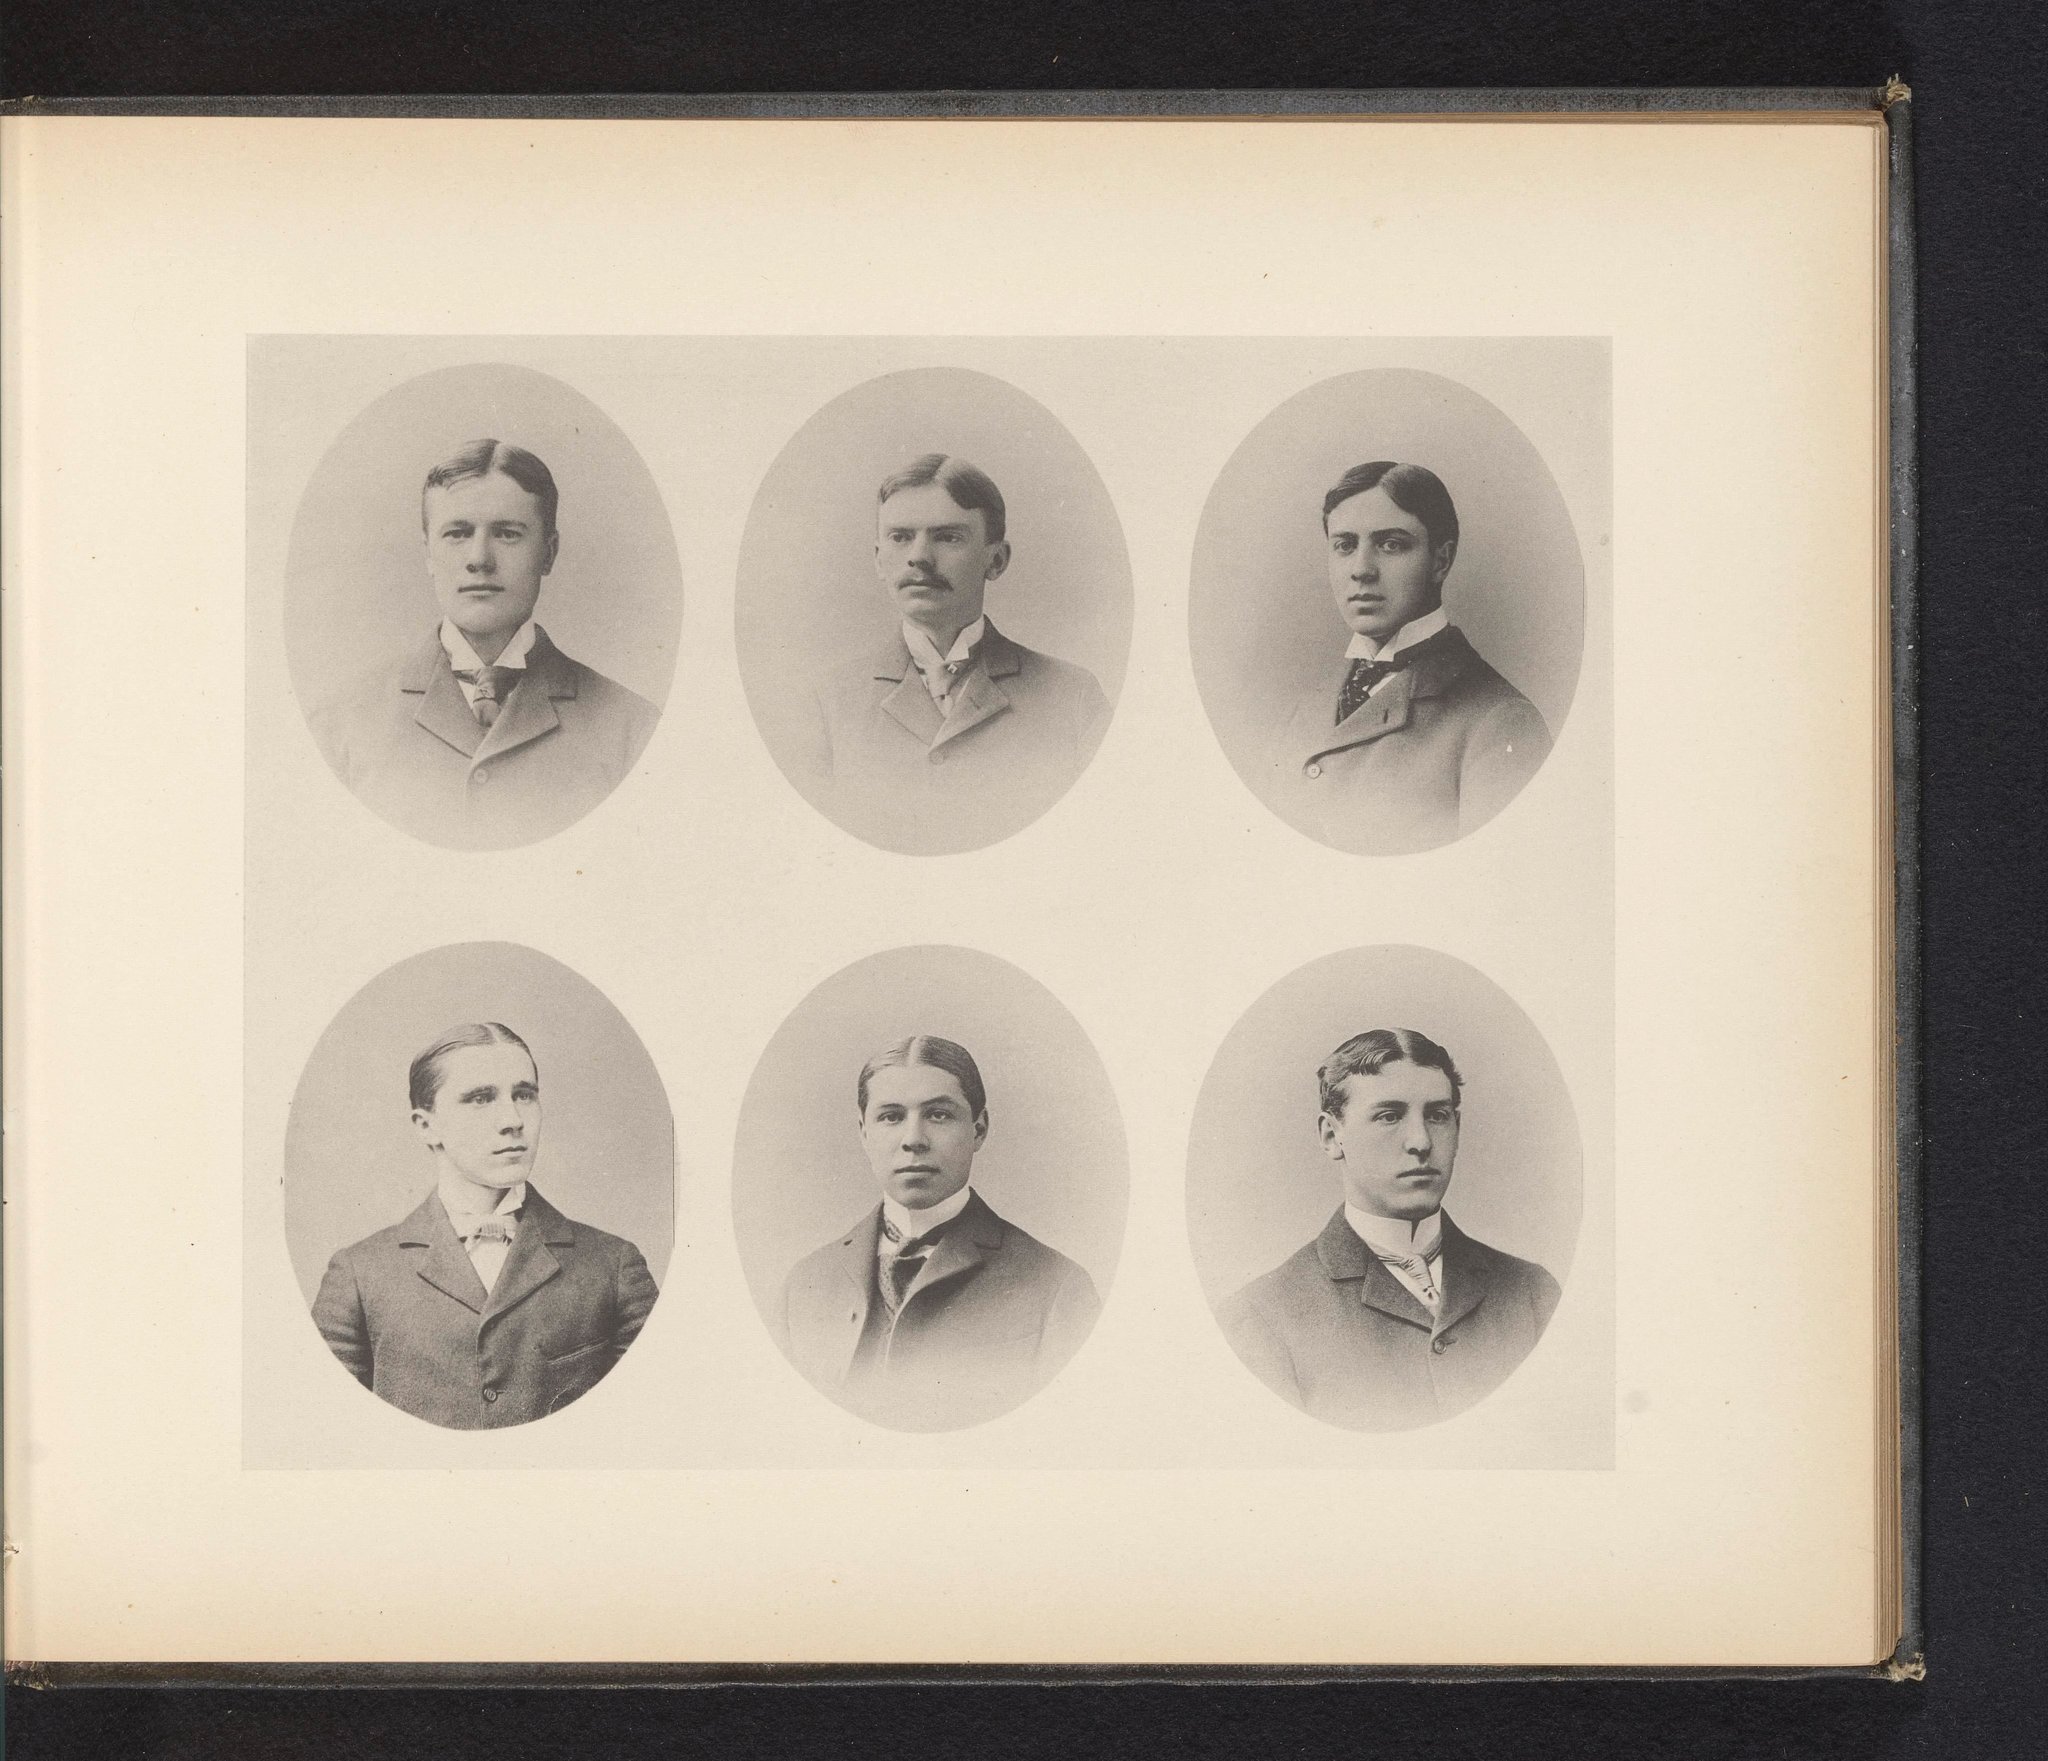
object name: page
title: Zes portretten van afgestudeerde studenten van Yale University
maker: Anonymous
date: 1895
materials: paper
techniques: photograph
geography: new york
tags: student